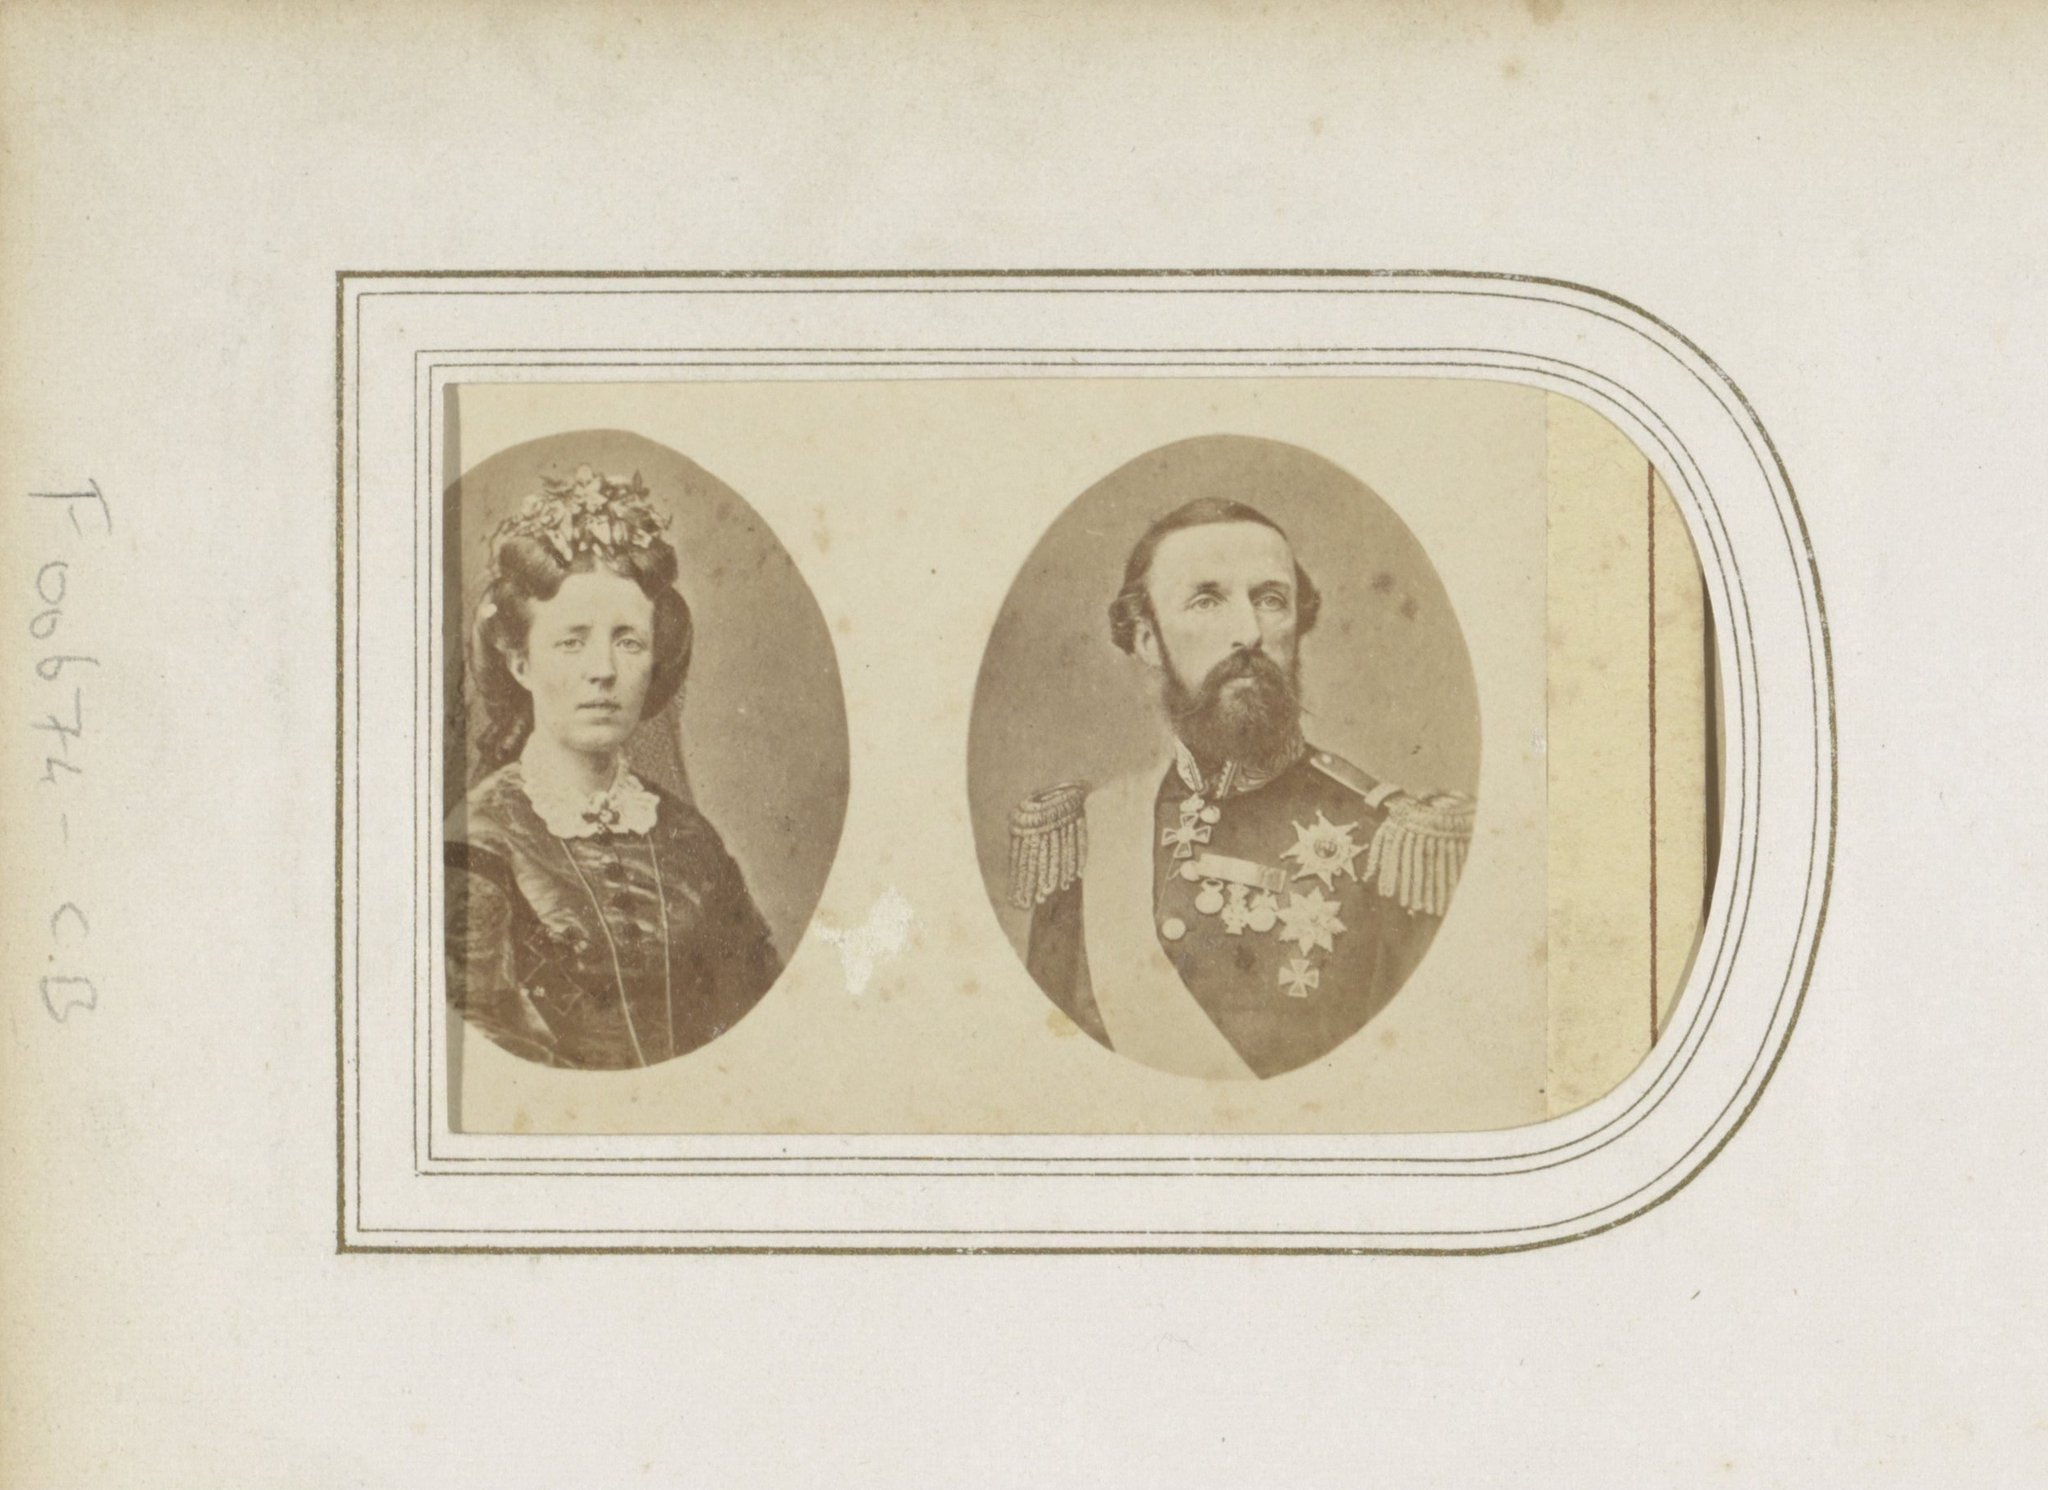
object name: carte de visite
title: Portretten van Sophia en Oscar, hertogin en hertog van Östergötland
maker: Anonymous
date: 1865-1880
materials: cardboard, paper, photographic support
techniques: albumen print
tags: historical persons, styles of hairdress - aa - ~ women, neck-gear ~ clothing, medals and other marks of military honour, ruler, sovereign, decorations, honours (as symbols of the state, etc.), (military) uniforms, beard, nobility and patriciate; chivalry, knighthood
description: Onderdeel van Fotoalbum met 123 cartes-de-visite van leden van Europese vorstenhuizen, politici en bekende personen.